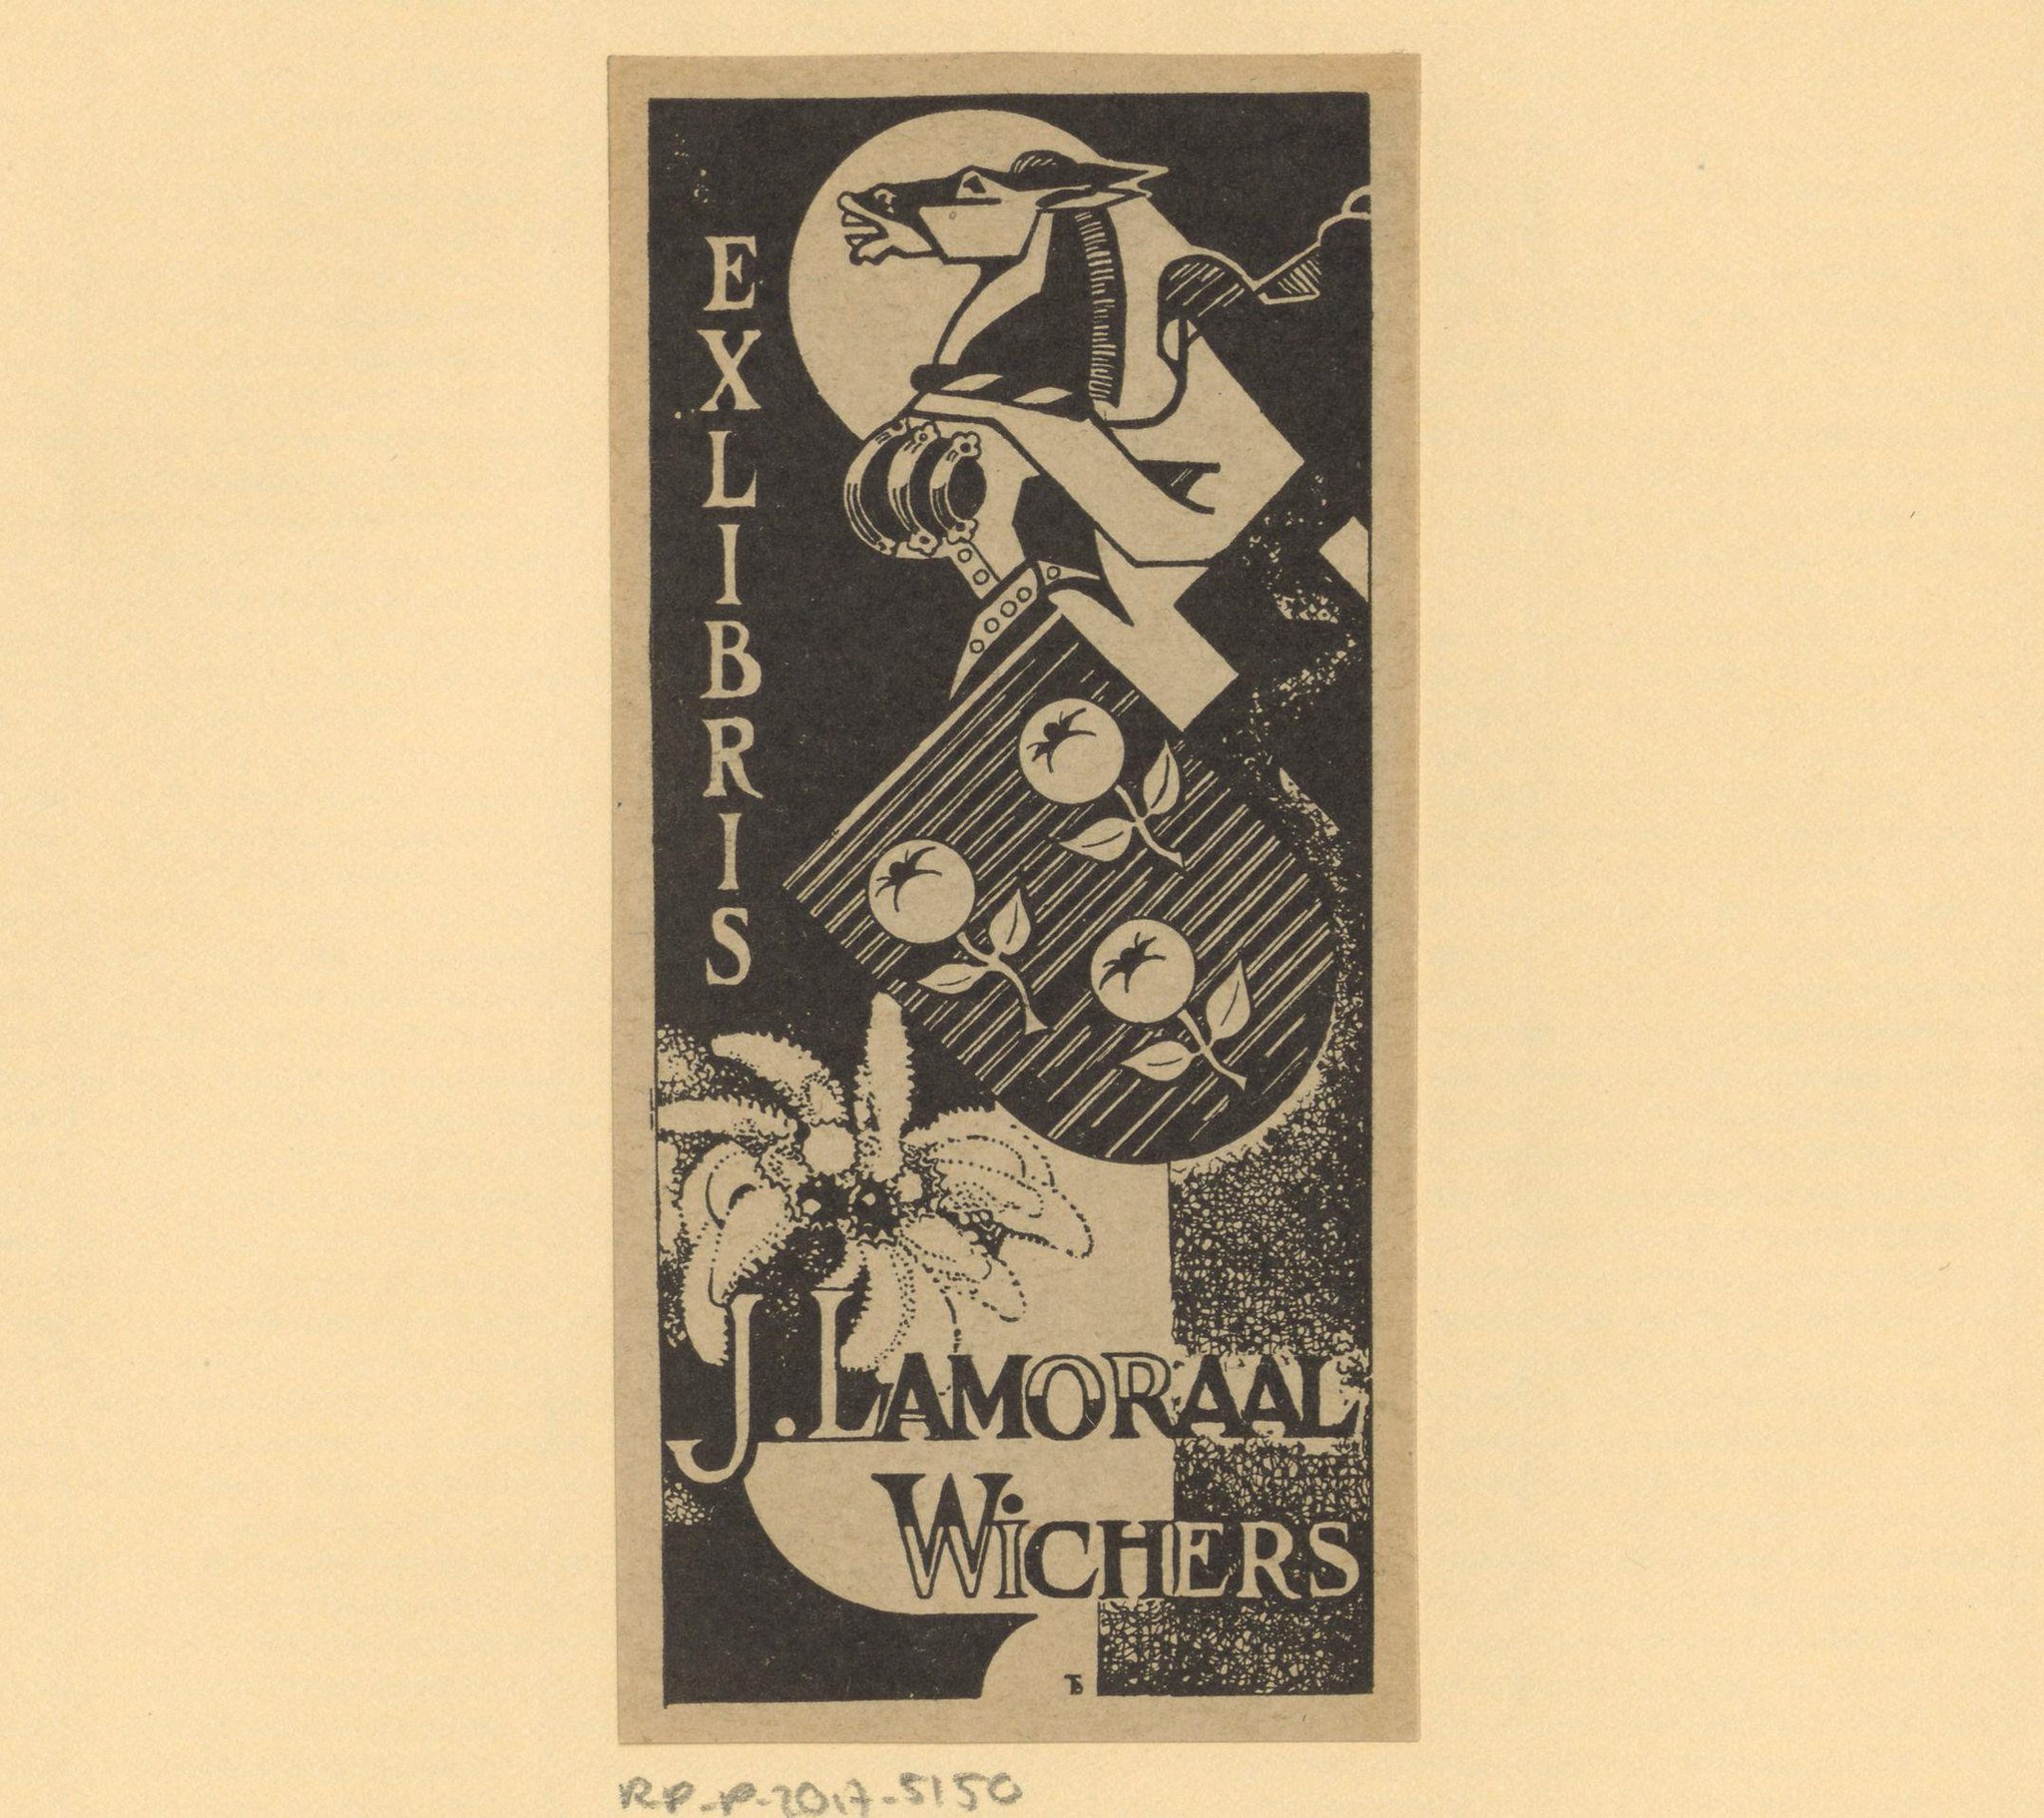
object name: bookplate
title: Ex libris van J. Lamoraal Wichers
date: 1937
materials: paper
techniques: printing block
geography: netherlands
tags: flowers, horse, armorial bearing, heraldry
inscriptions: inscription: ‘T. Bogtman - 1937’